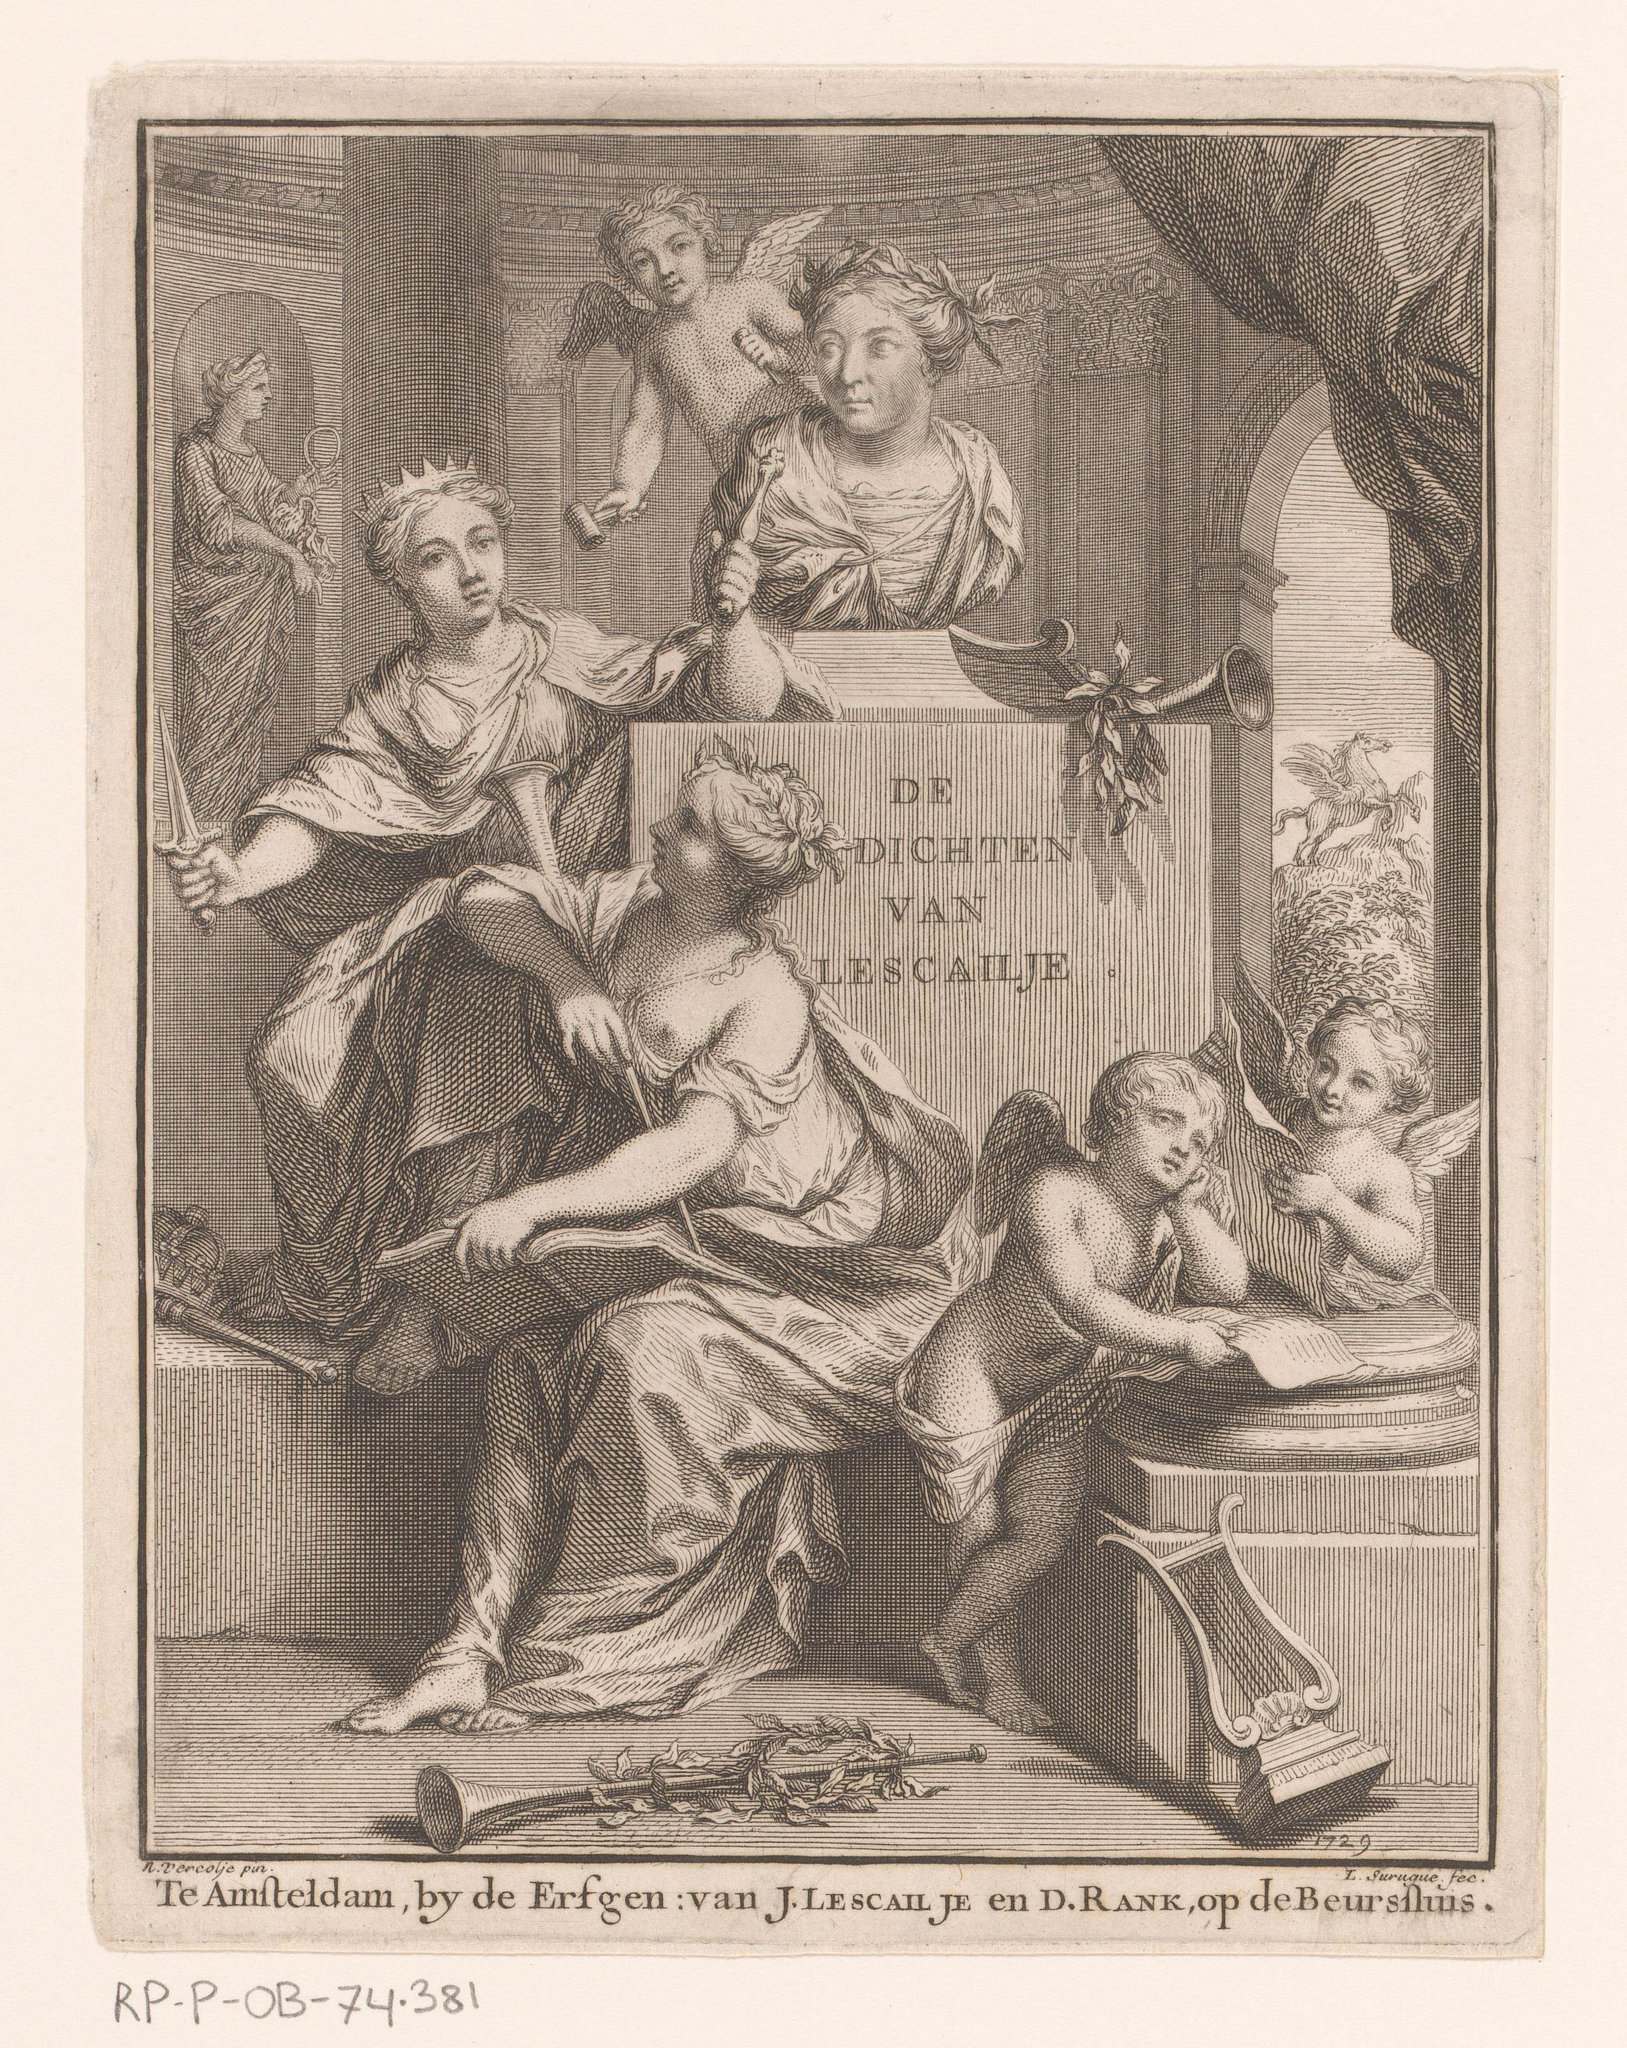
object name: titelblad, titelpagina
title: Titelpagina voor: Katharyne Lescailje, De Mengelpoëzy van Katharyne Lescailje, 1731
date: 1731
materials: paper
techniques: engraving, etching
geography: amsterdam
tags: katharina lescaille, the muses acting together (as group) - attributes, writer, poet, author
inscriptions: collector's mark: Lugt 240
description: Titelpagina voor: Lescailje, Katharyne. De Mengelpoëzy van Katharyne Lescailje. Amsterdam: De Erfgenaamen van J. Lescailje en D. Rank op de Beurssluis, 1731.